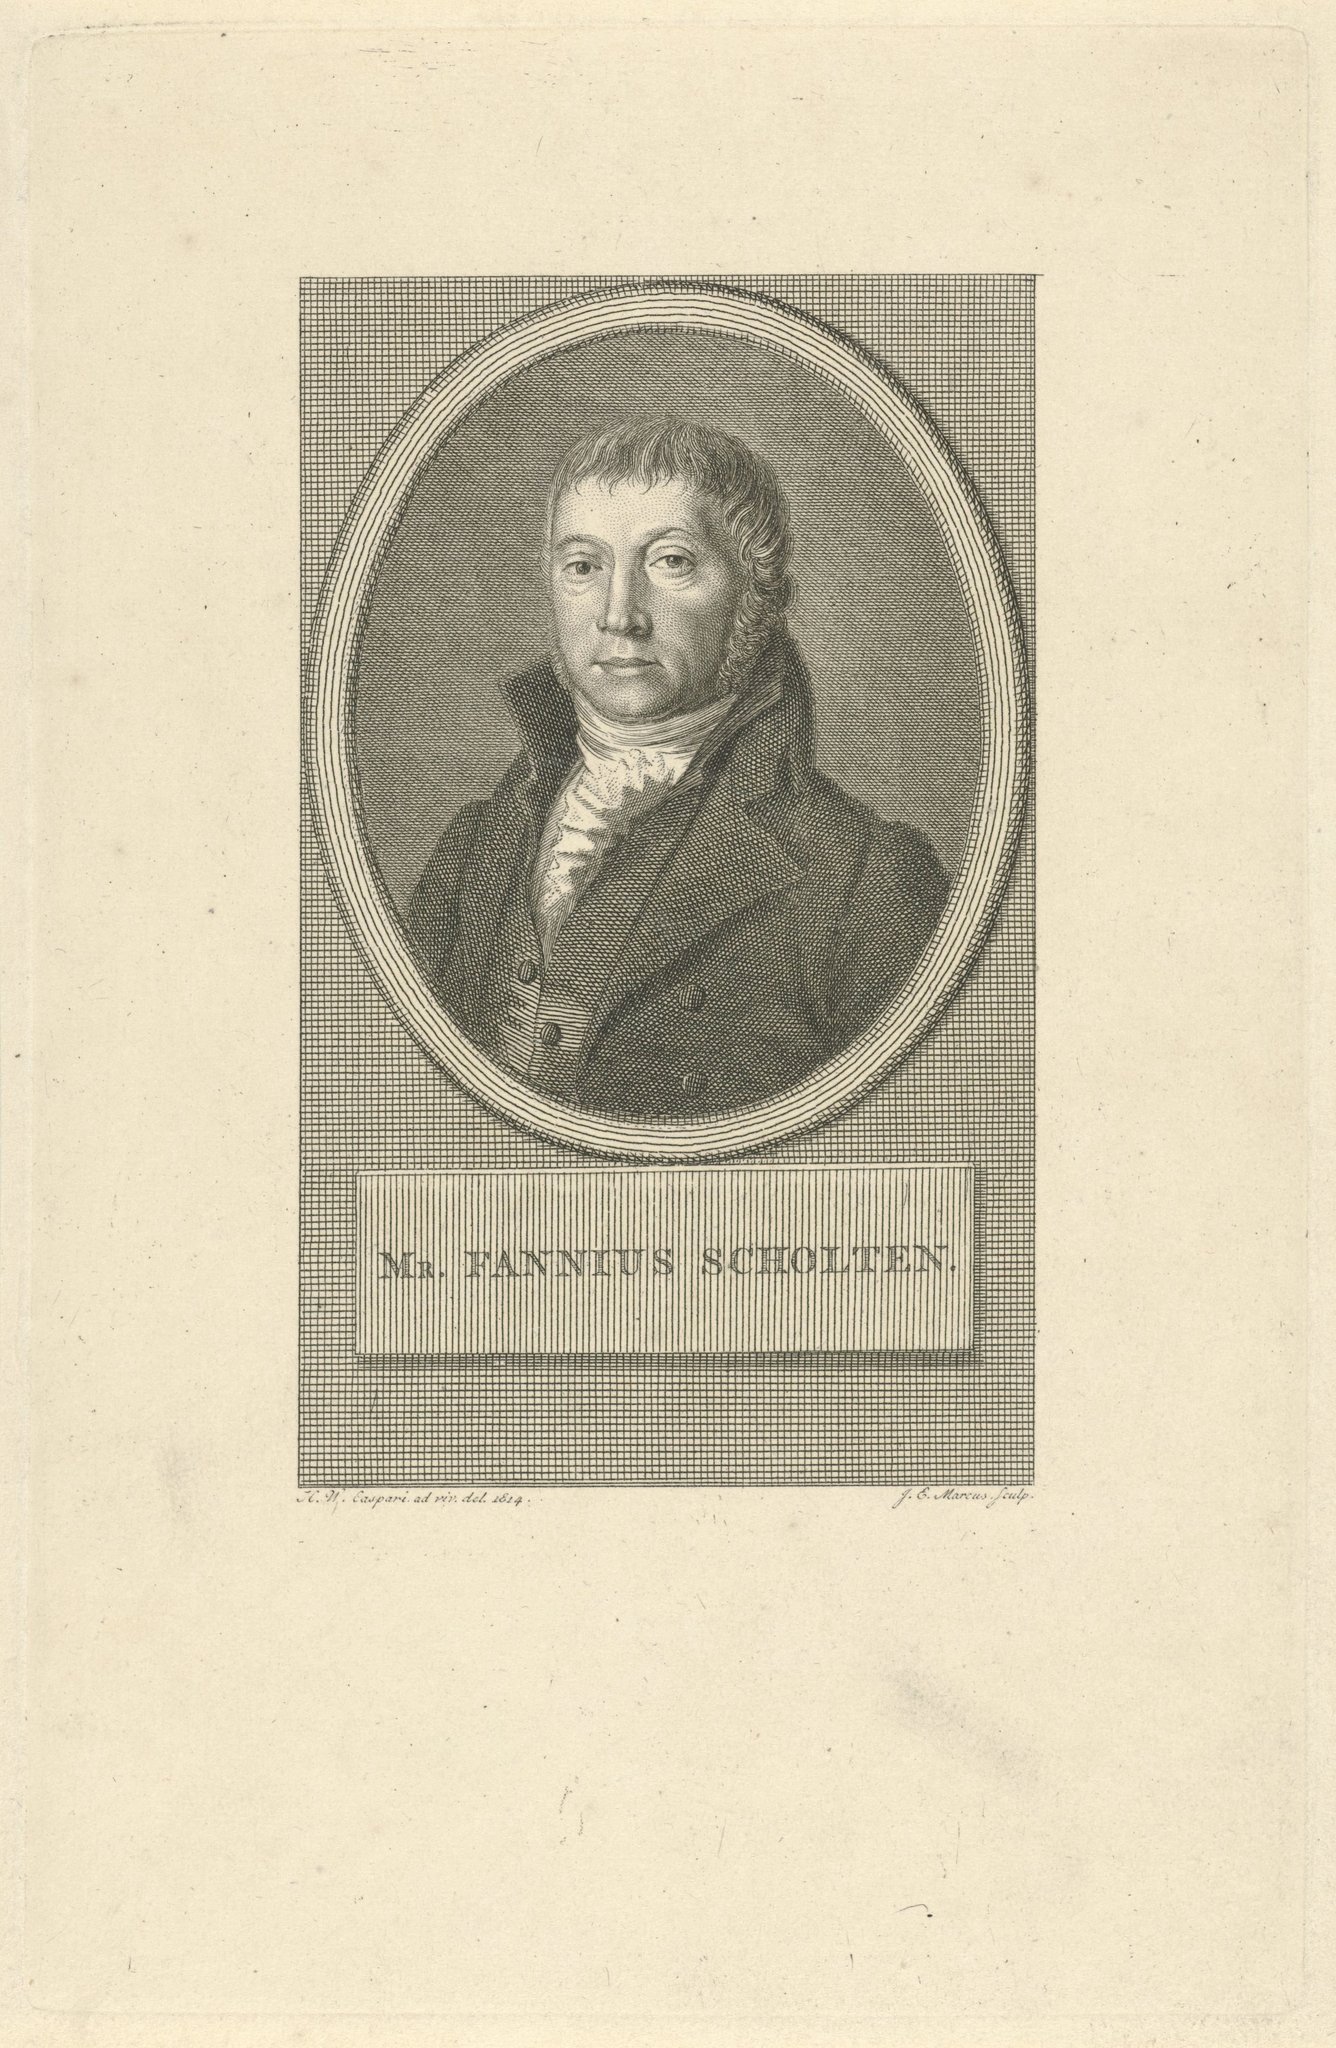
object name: print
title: Portret van Cornelis Anthony Fannius Scholten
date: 1814-1817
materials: paper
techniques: engraving, etching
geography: amsterdam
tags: cornelis anthony fannius scholten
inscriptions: collector's mark: Lugt 2228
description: Prent ook gebruikt in: Herman Bosscha, Geschiedenis der Nederlandsche staatsomwenteling in 1813. 4 dln. Amsterdam: P. den Hengt en zn. en J. van der Hey, 1817.